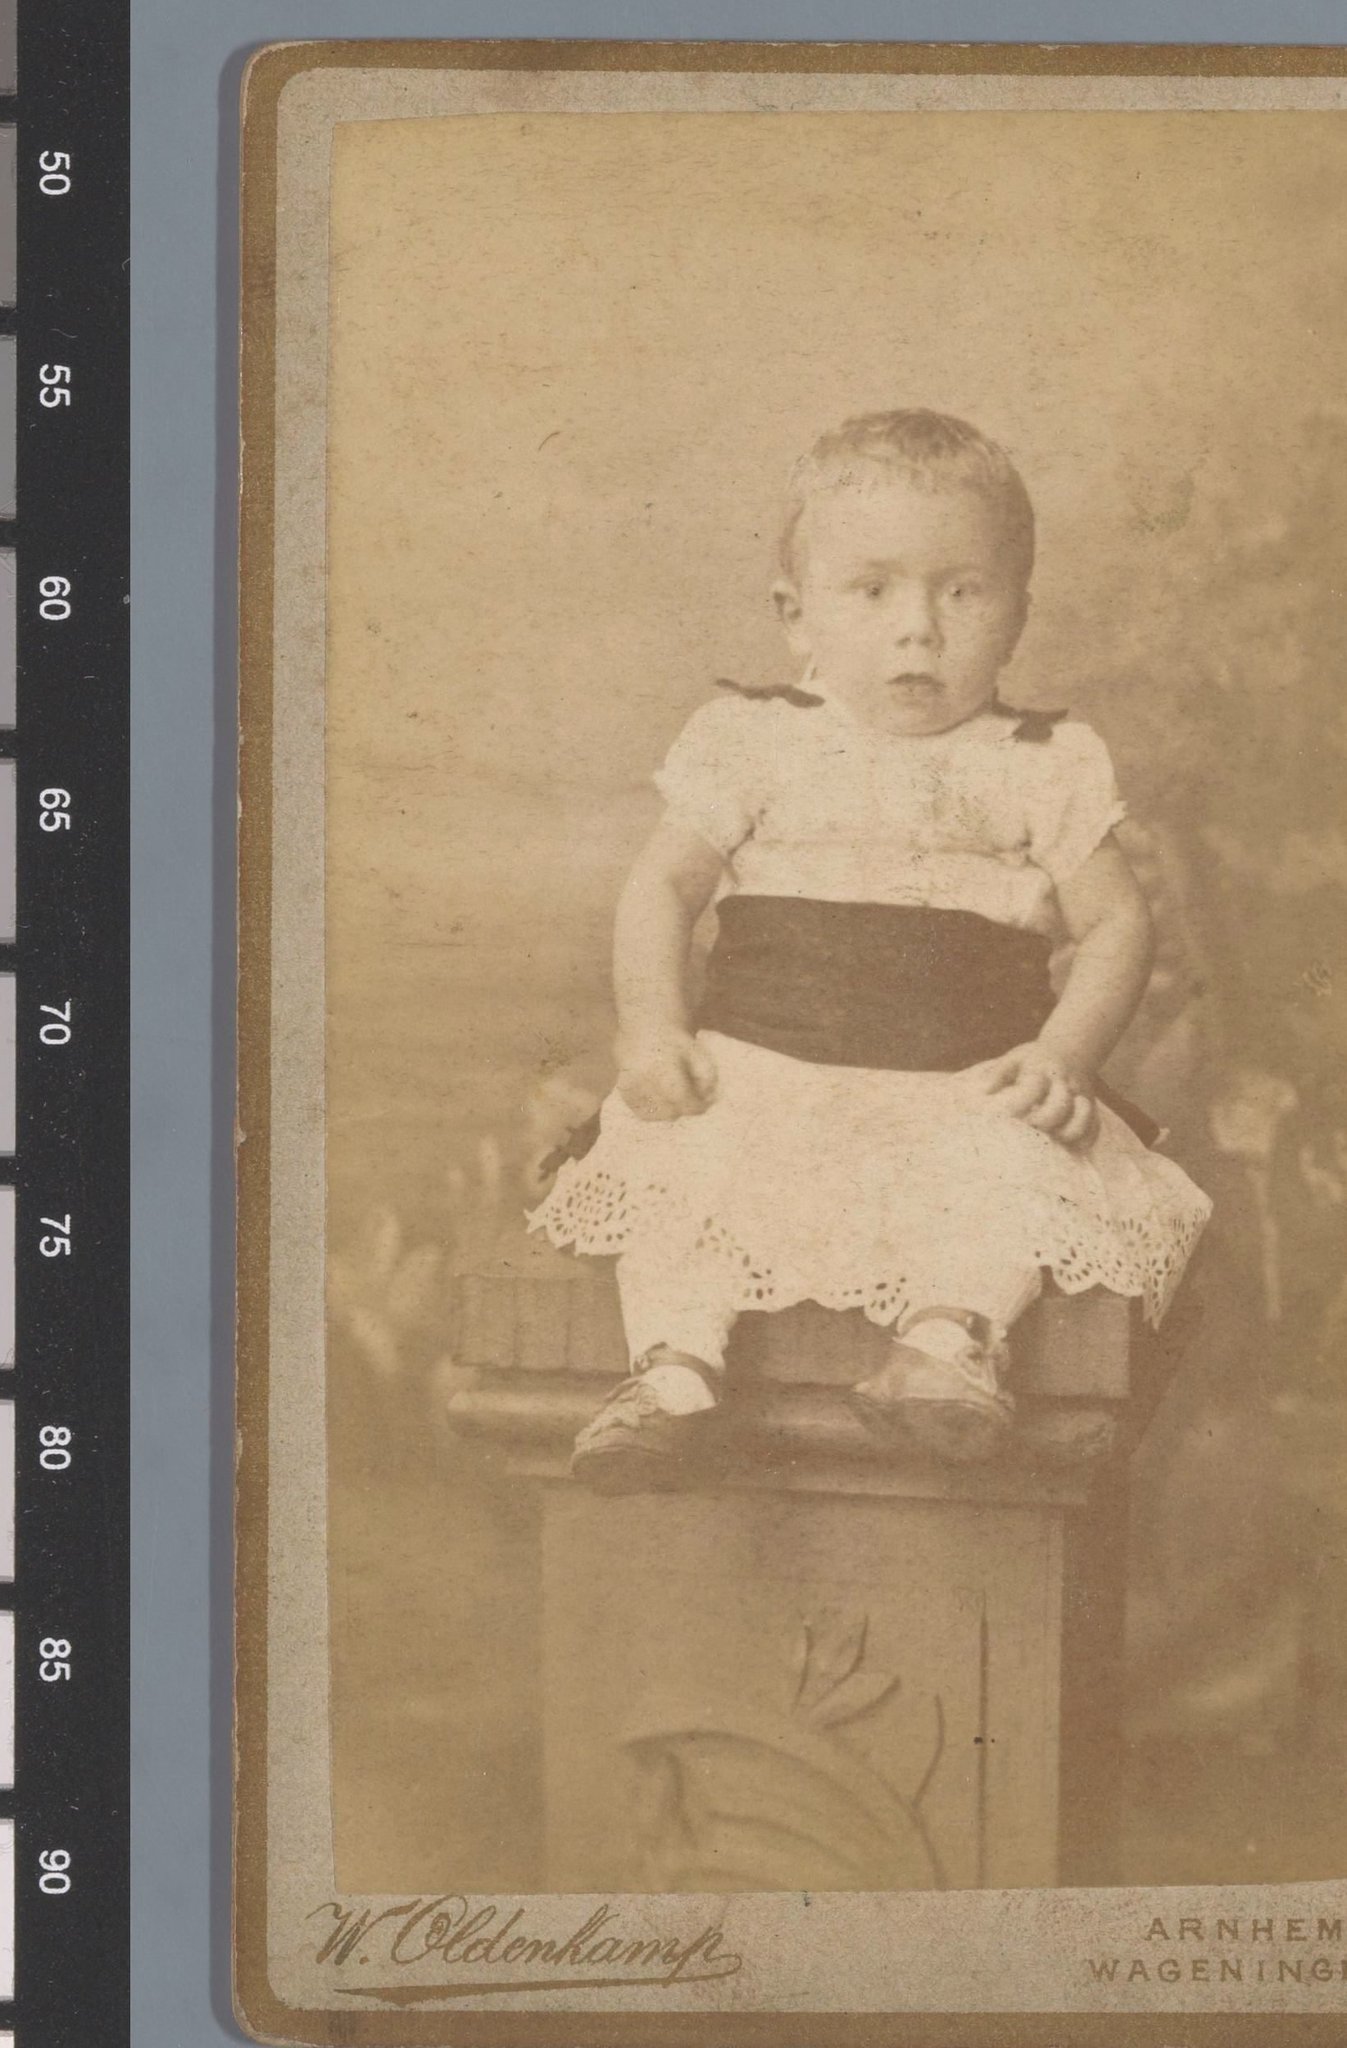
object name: carte de visite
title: Portret van een onbekend kind op een zuil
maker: willem oldenkamp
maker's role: fotograaf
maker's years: 1864-1921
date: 1885-1915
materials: cardboard, paper, photographic support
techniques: albumen print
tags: studio requisites ~ photographer, half-column, pilaster ~ architecture, child (at home)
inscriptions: name: ‘Photografische inrichtingen van W. Oldenkamp Arnhem Ridderstraat 22. Wageningen naast het Station. Negativen worden voor nabestelling bewaard.’, name: ‘W. Oldenkamp Arnhem. Wageningen’, name: ‘Trapp & Münch, Berlin’